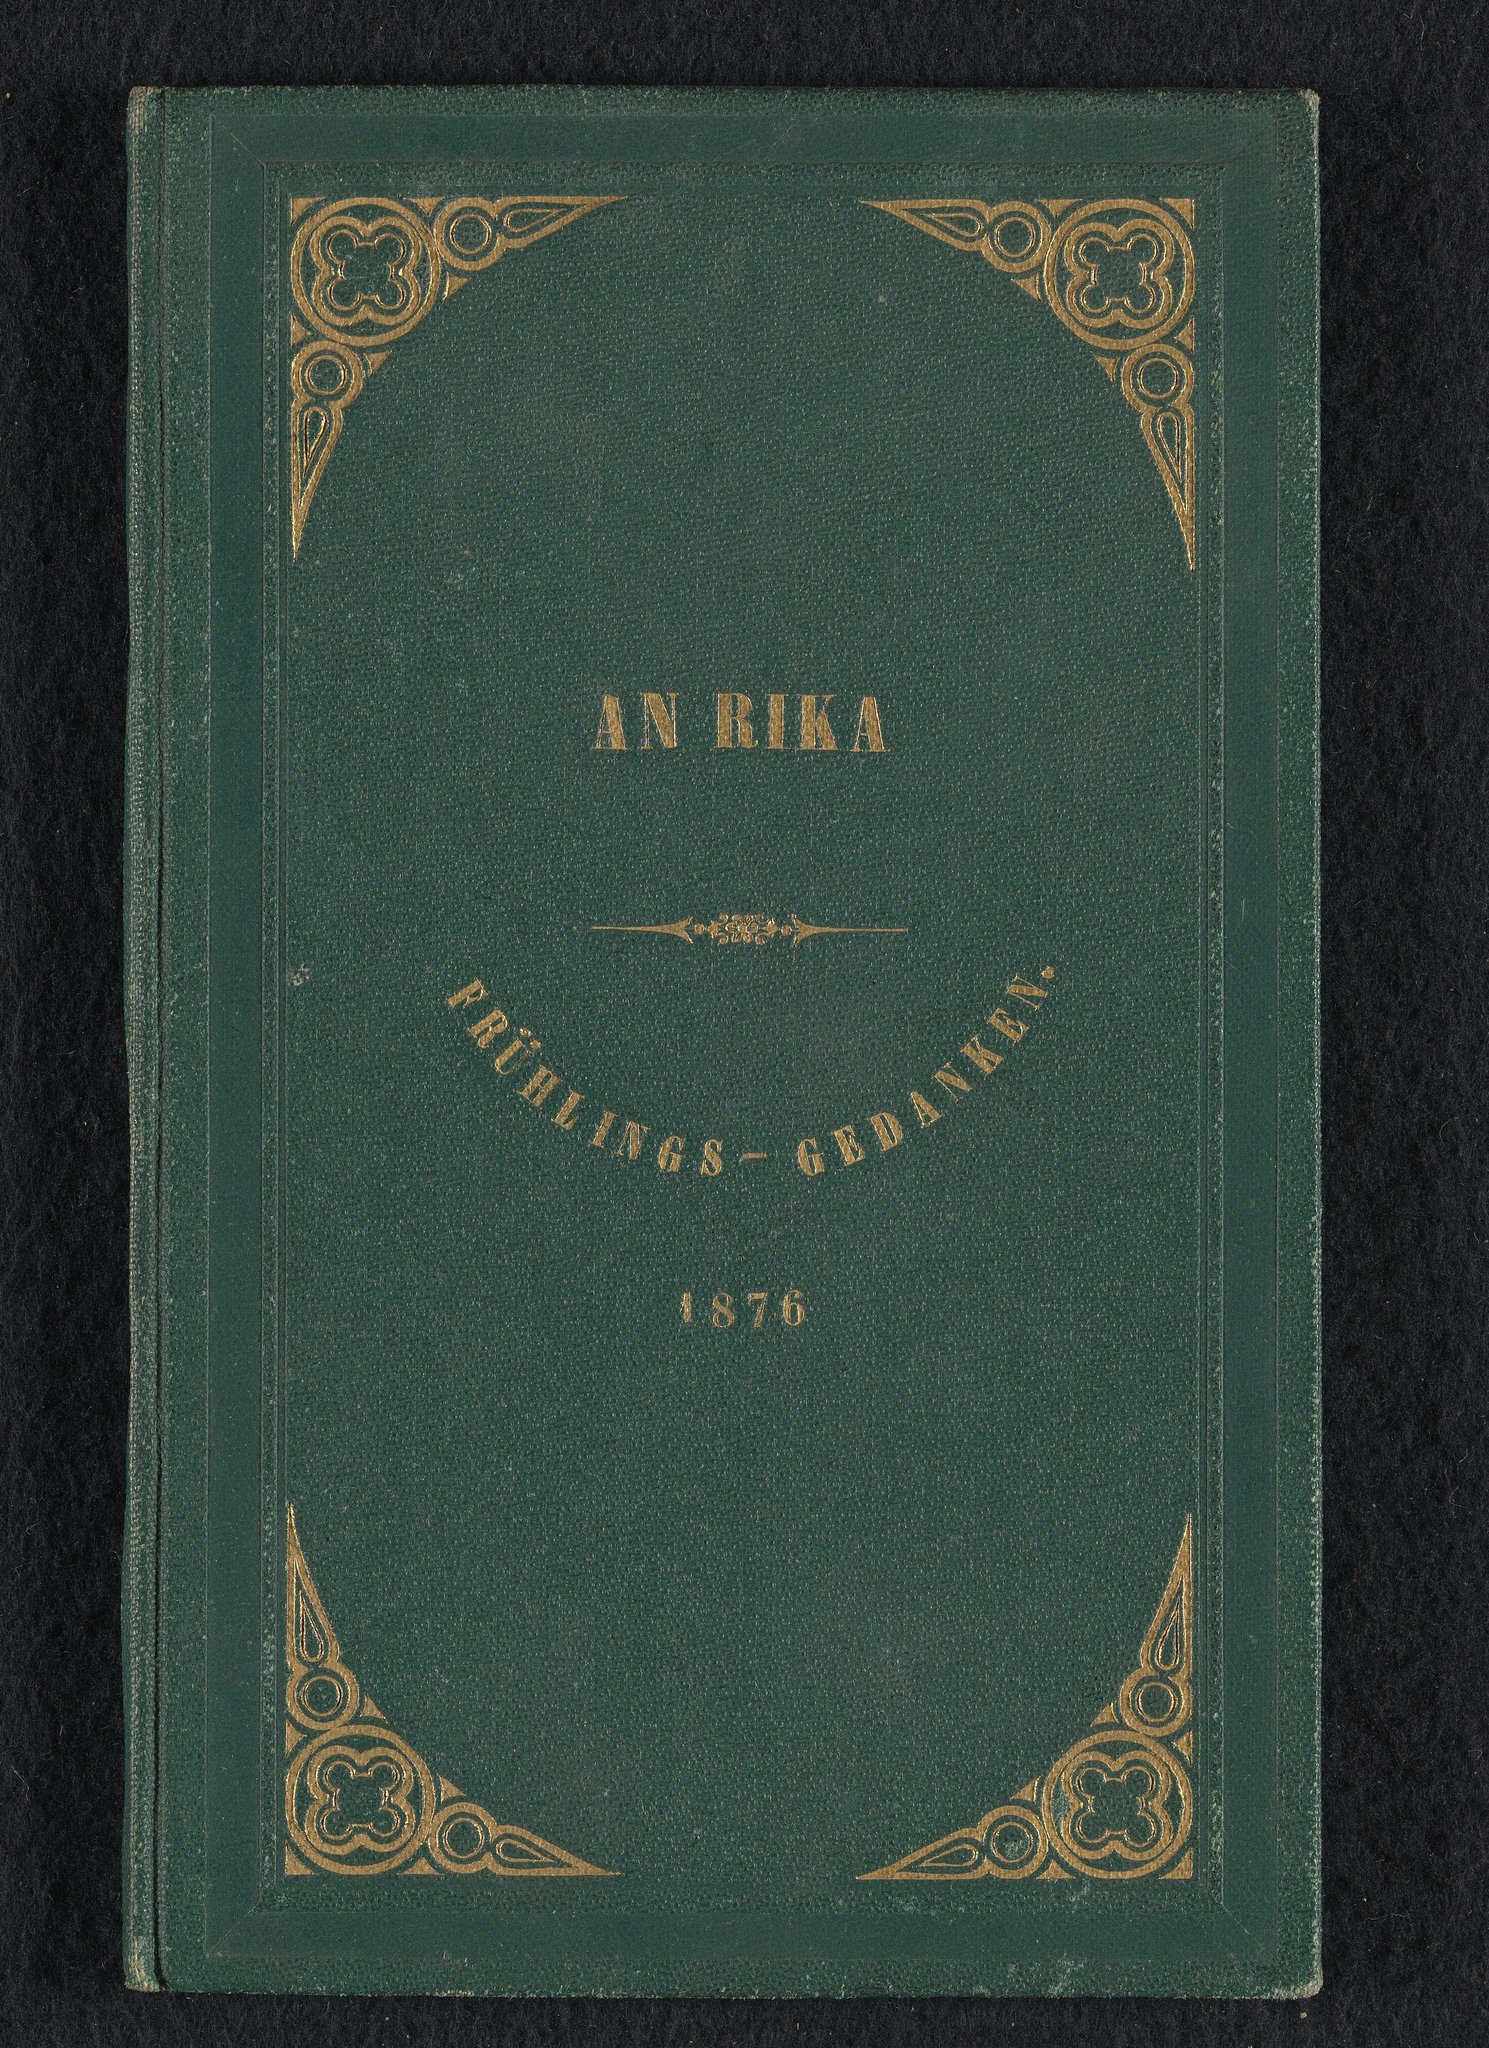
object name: book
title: An Rika: Frühlings-Gedanken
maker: w.e. frowein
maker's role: schrijver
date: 1876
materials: cardboard, leather, paper, textile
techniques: albumen print, letterpress printing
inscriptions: inscription: ‘Aan/ Mevr. Kroon/ van/ Cp;’